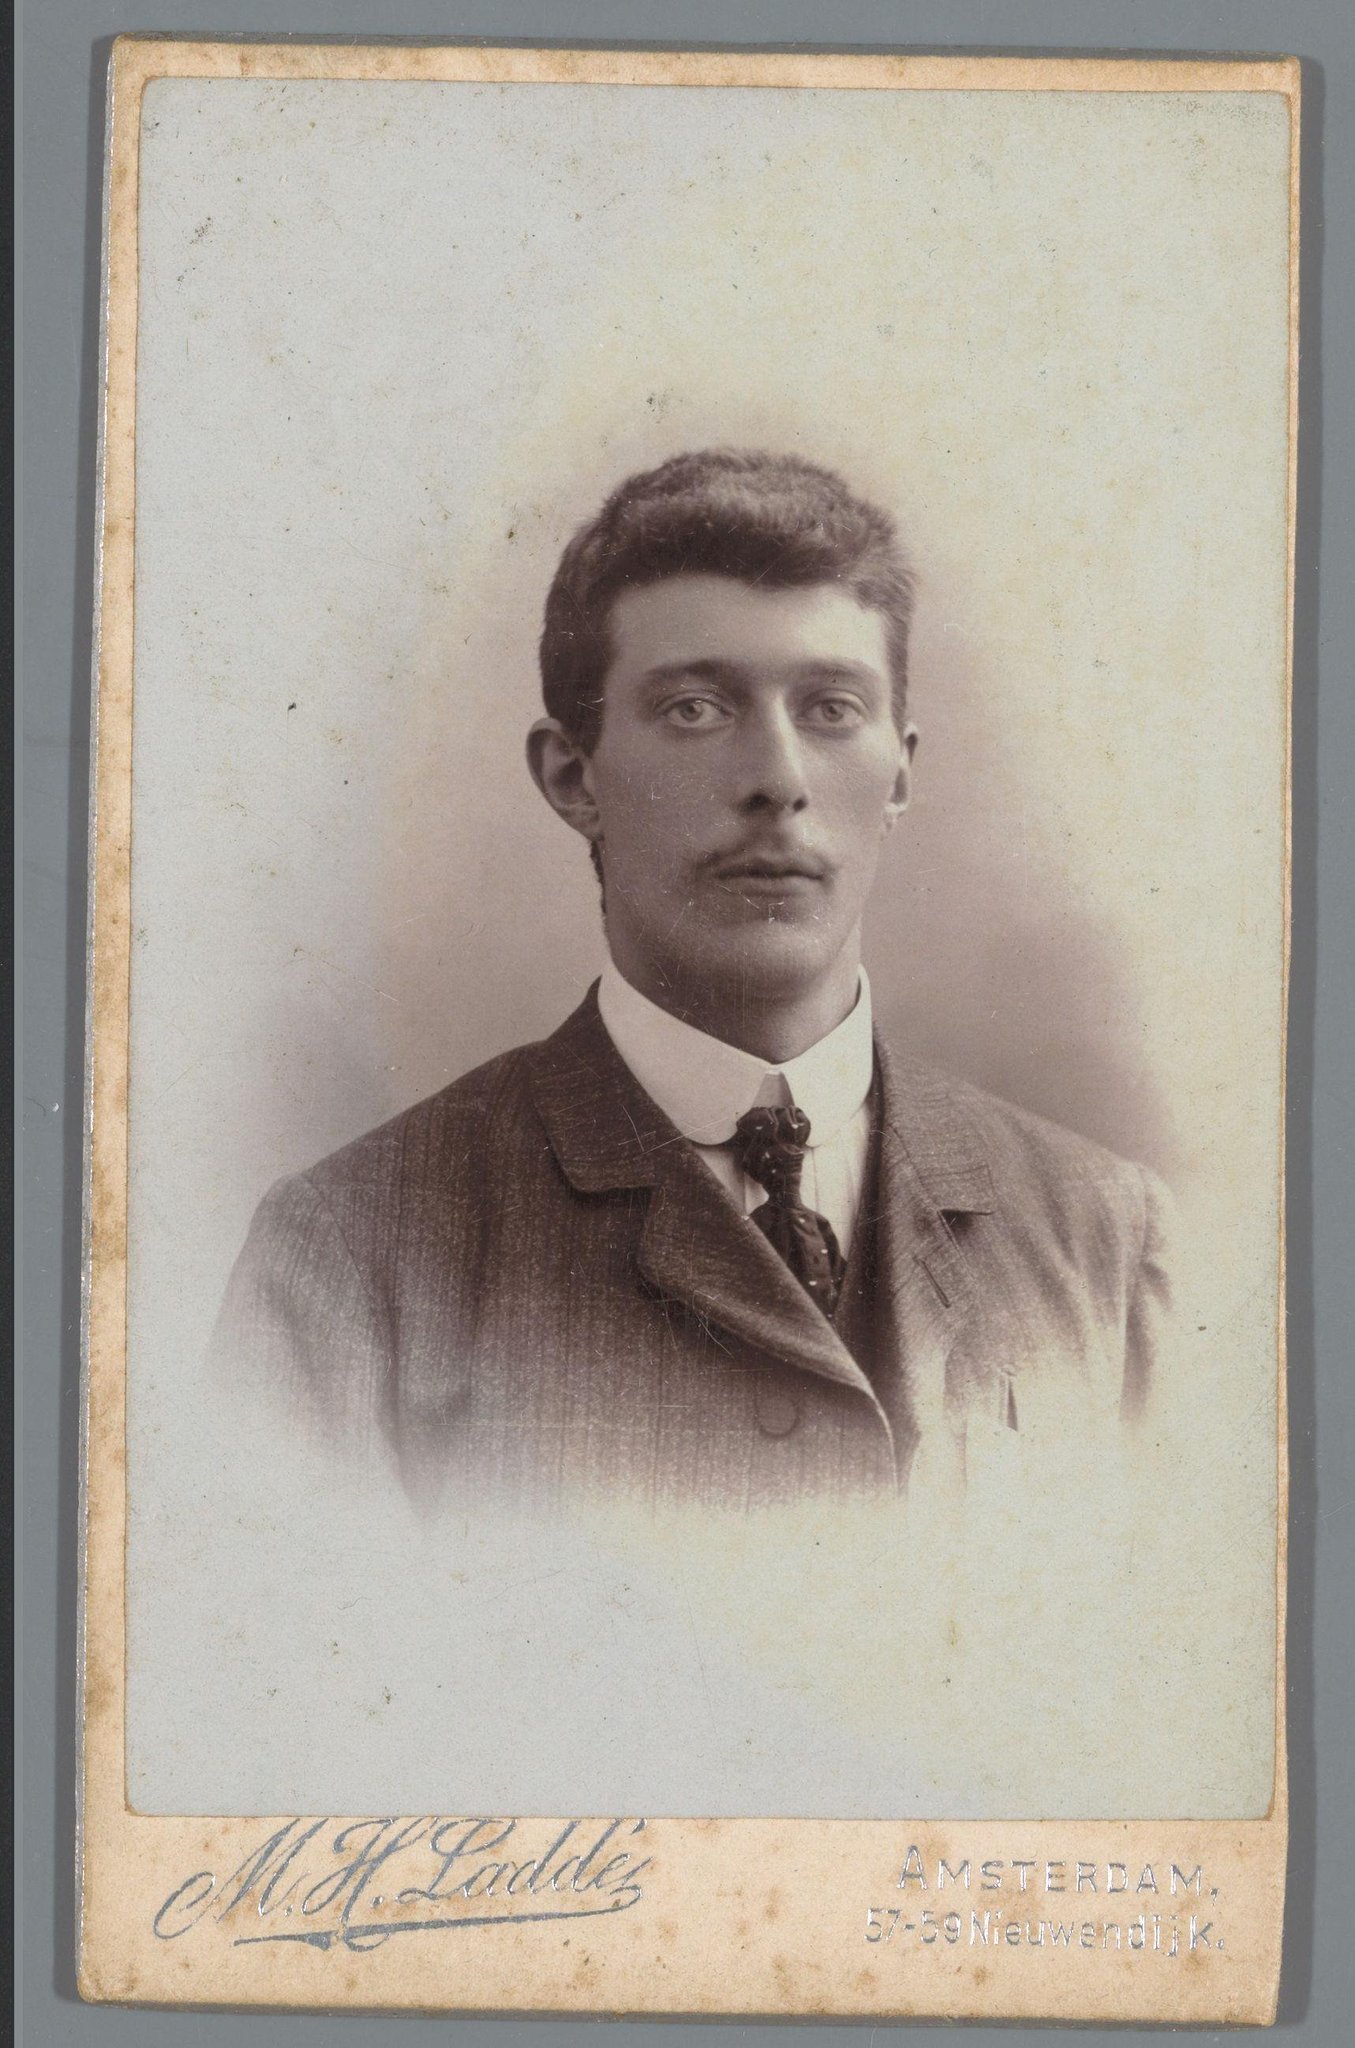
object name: carte de visite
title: Portret van een onbekende man, aangeduid als Hubert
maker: machiel hendricus laddé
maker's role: fotograaf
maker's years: 1866-1932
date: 1892-1906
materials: cardboard, photographic support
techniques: collodion silver print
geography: amsterdam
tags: adult man, historical persons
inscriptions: number: ‘84261’, inscription: ‘Hubert’, address: ‘M. H. Laddé/ AMSTERDAM./ 57-59 Nieuwendijk.’